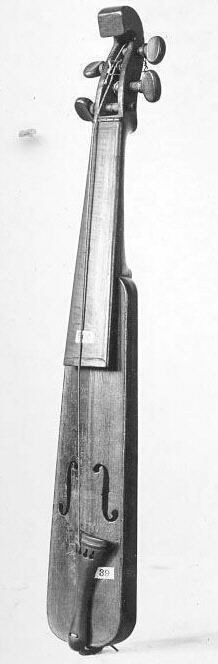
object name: pochette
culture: french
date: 1701-1800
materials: wood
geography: france